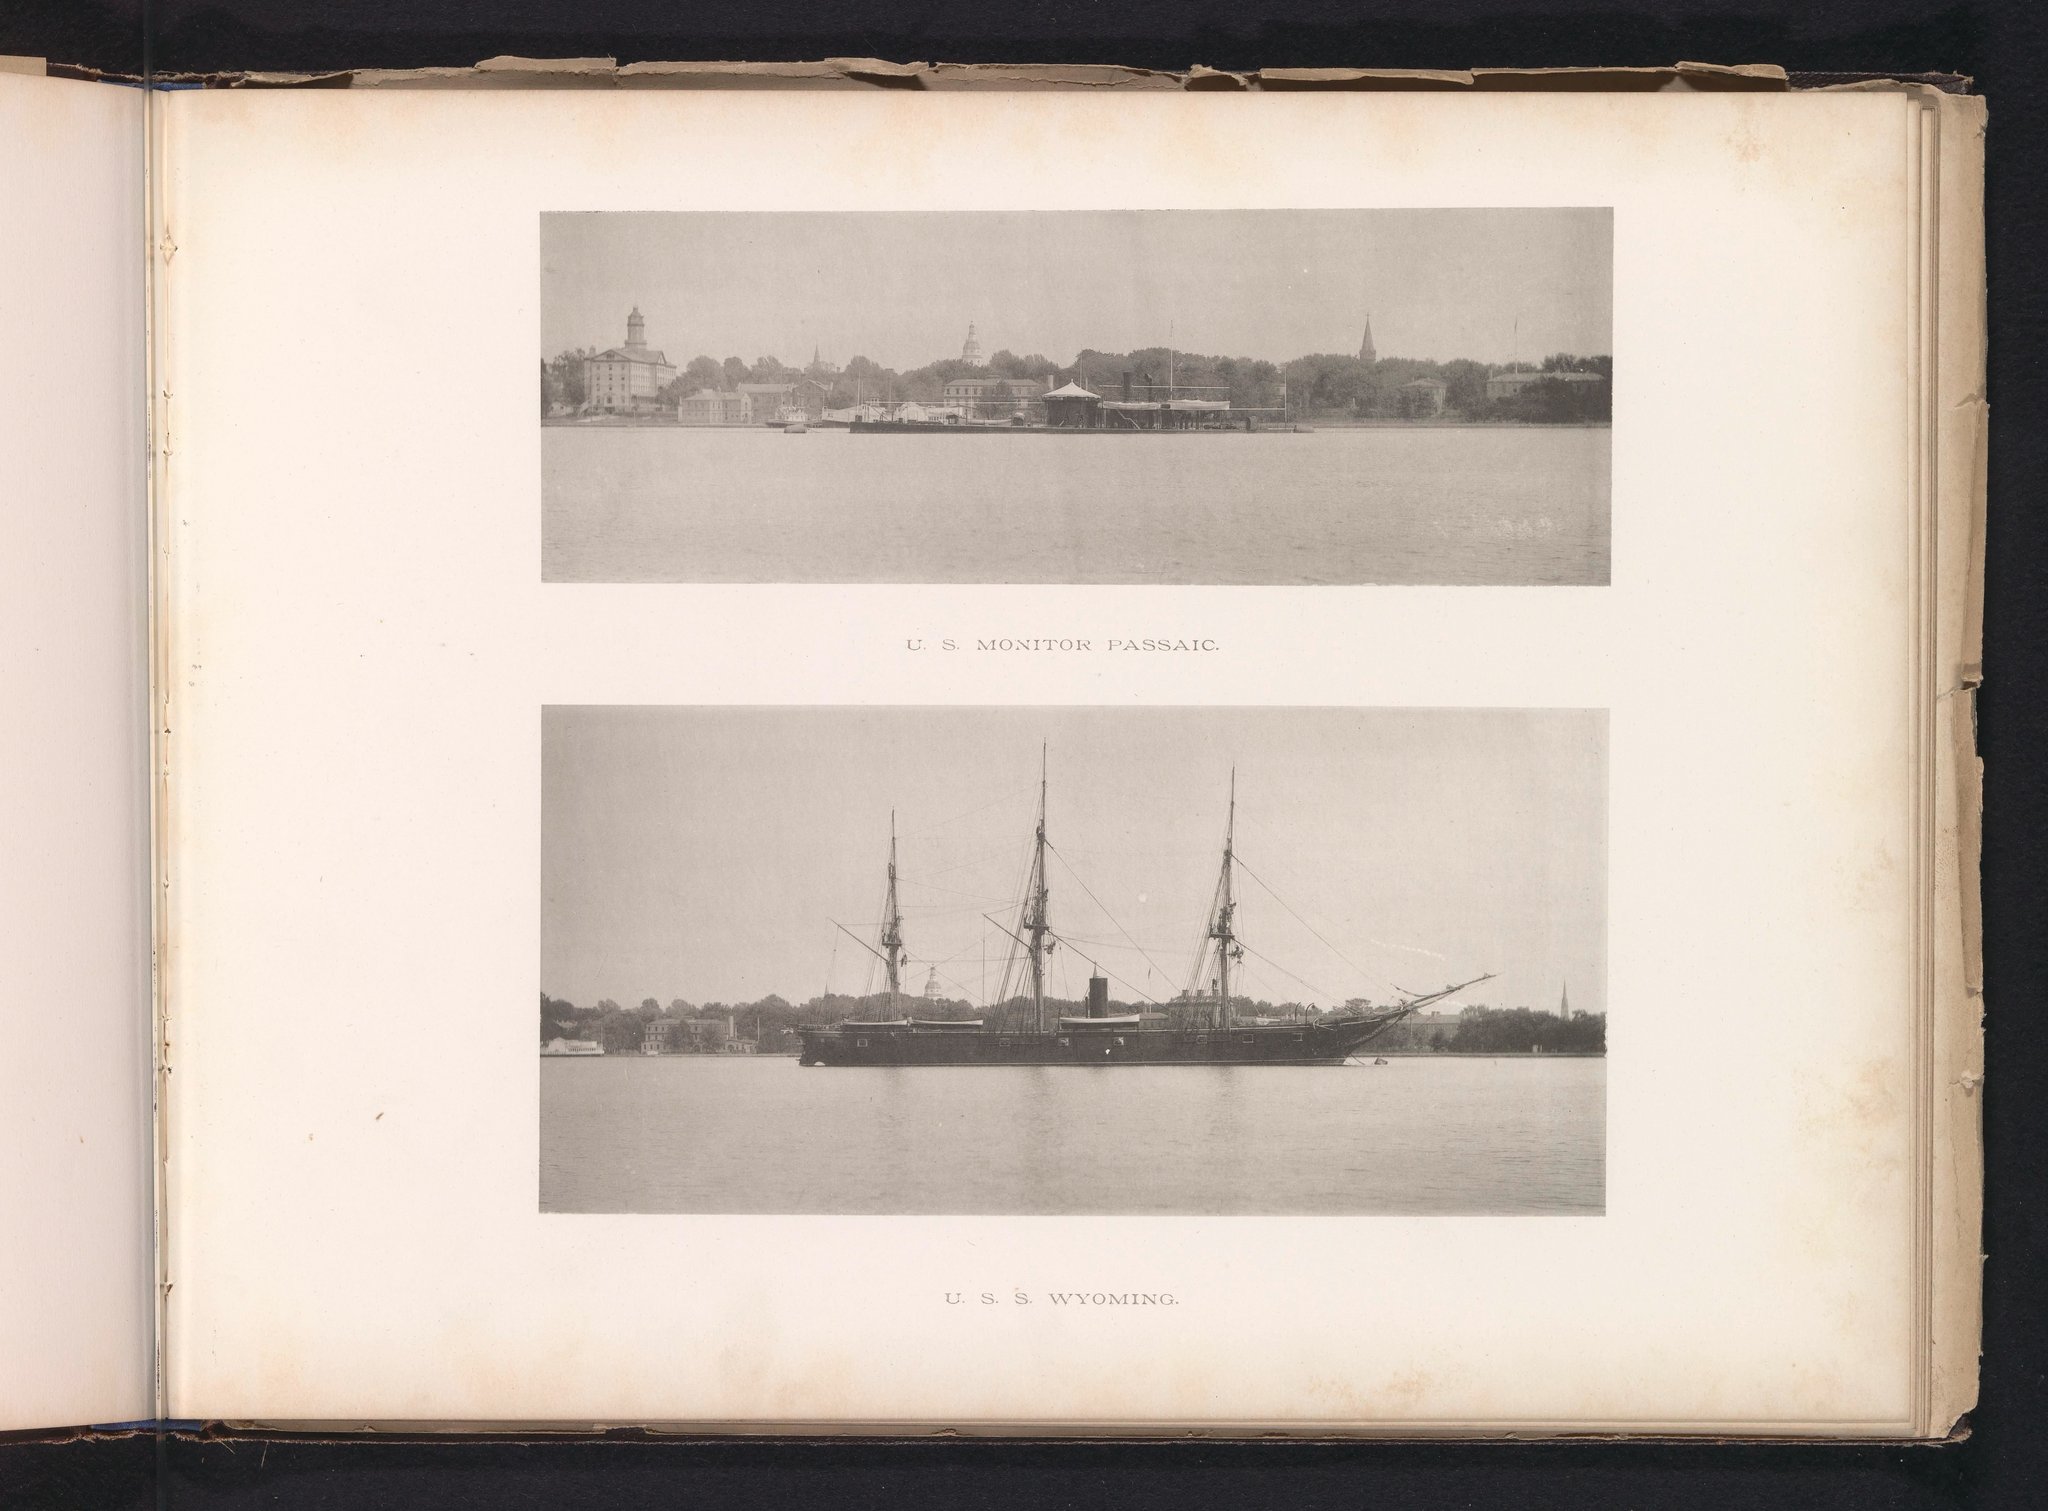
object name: page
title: U.S. Monitor Passaic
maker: edward h. hart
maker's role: publisher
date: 1885-1890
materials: paper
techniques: photograph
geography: new york city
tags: ship's portrait